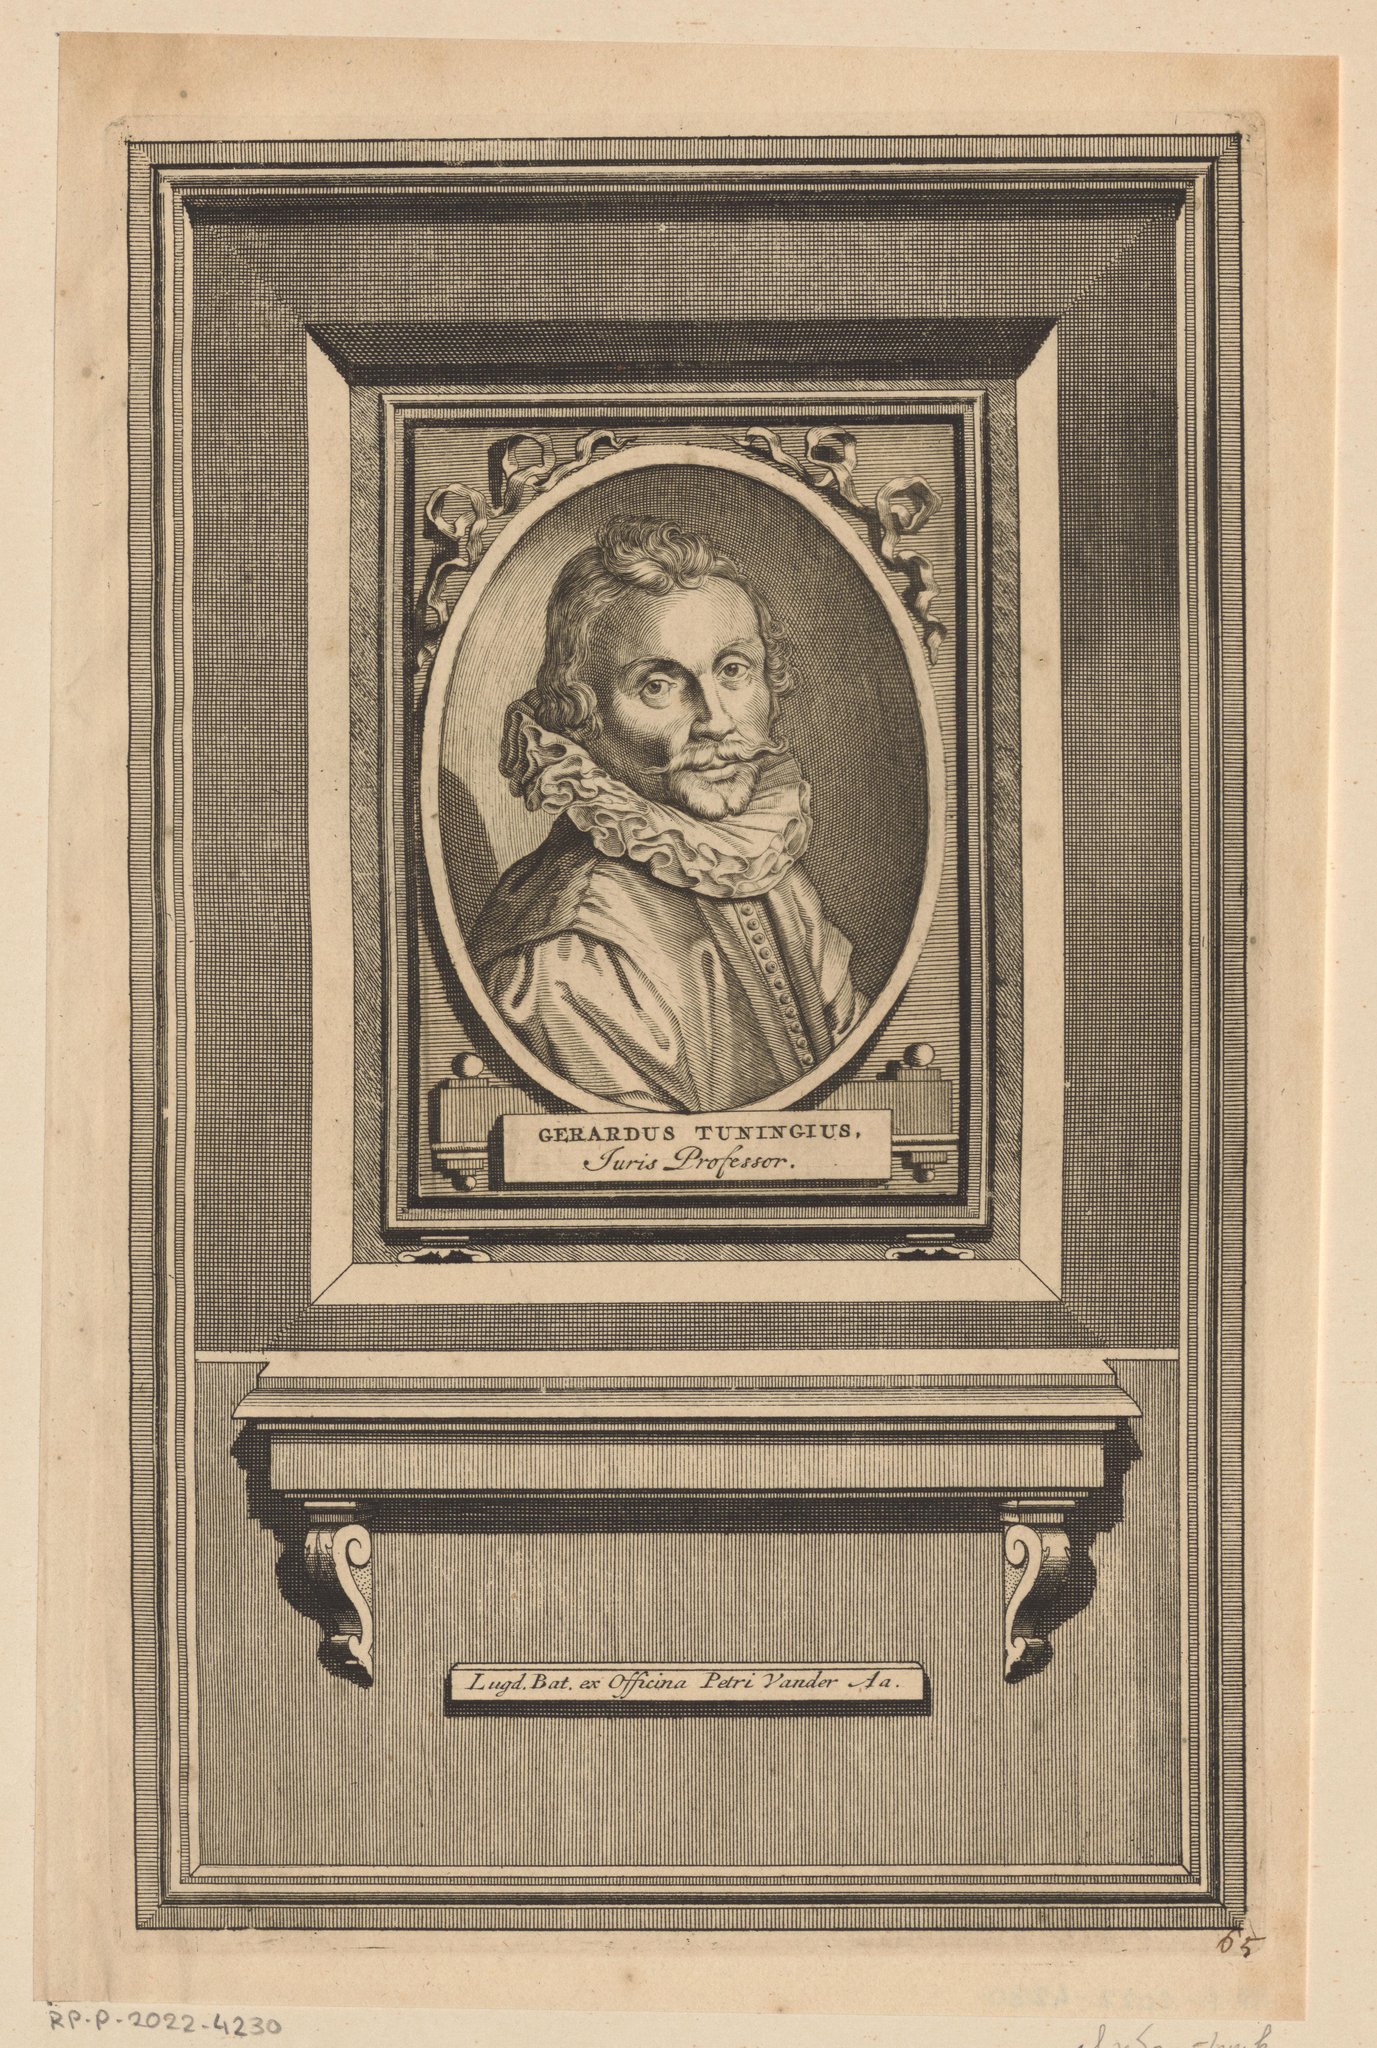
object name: print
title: Beroemde mannen aan de universiteit van Leiden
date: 1716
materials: paper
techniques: engraving, etching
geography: leiden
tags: brussels, scholar, philosopher, historical persons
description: Rechtsonder handgeschreven genummerd: 65.